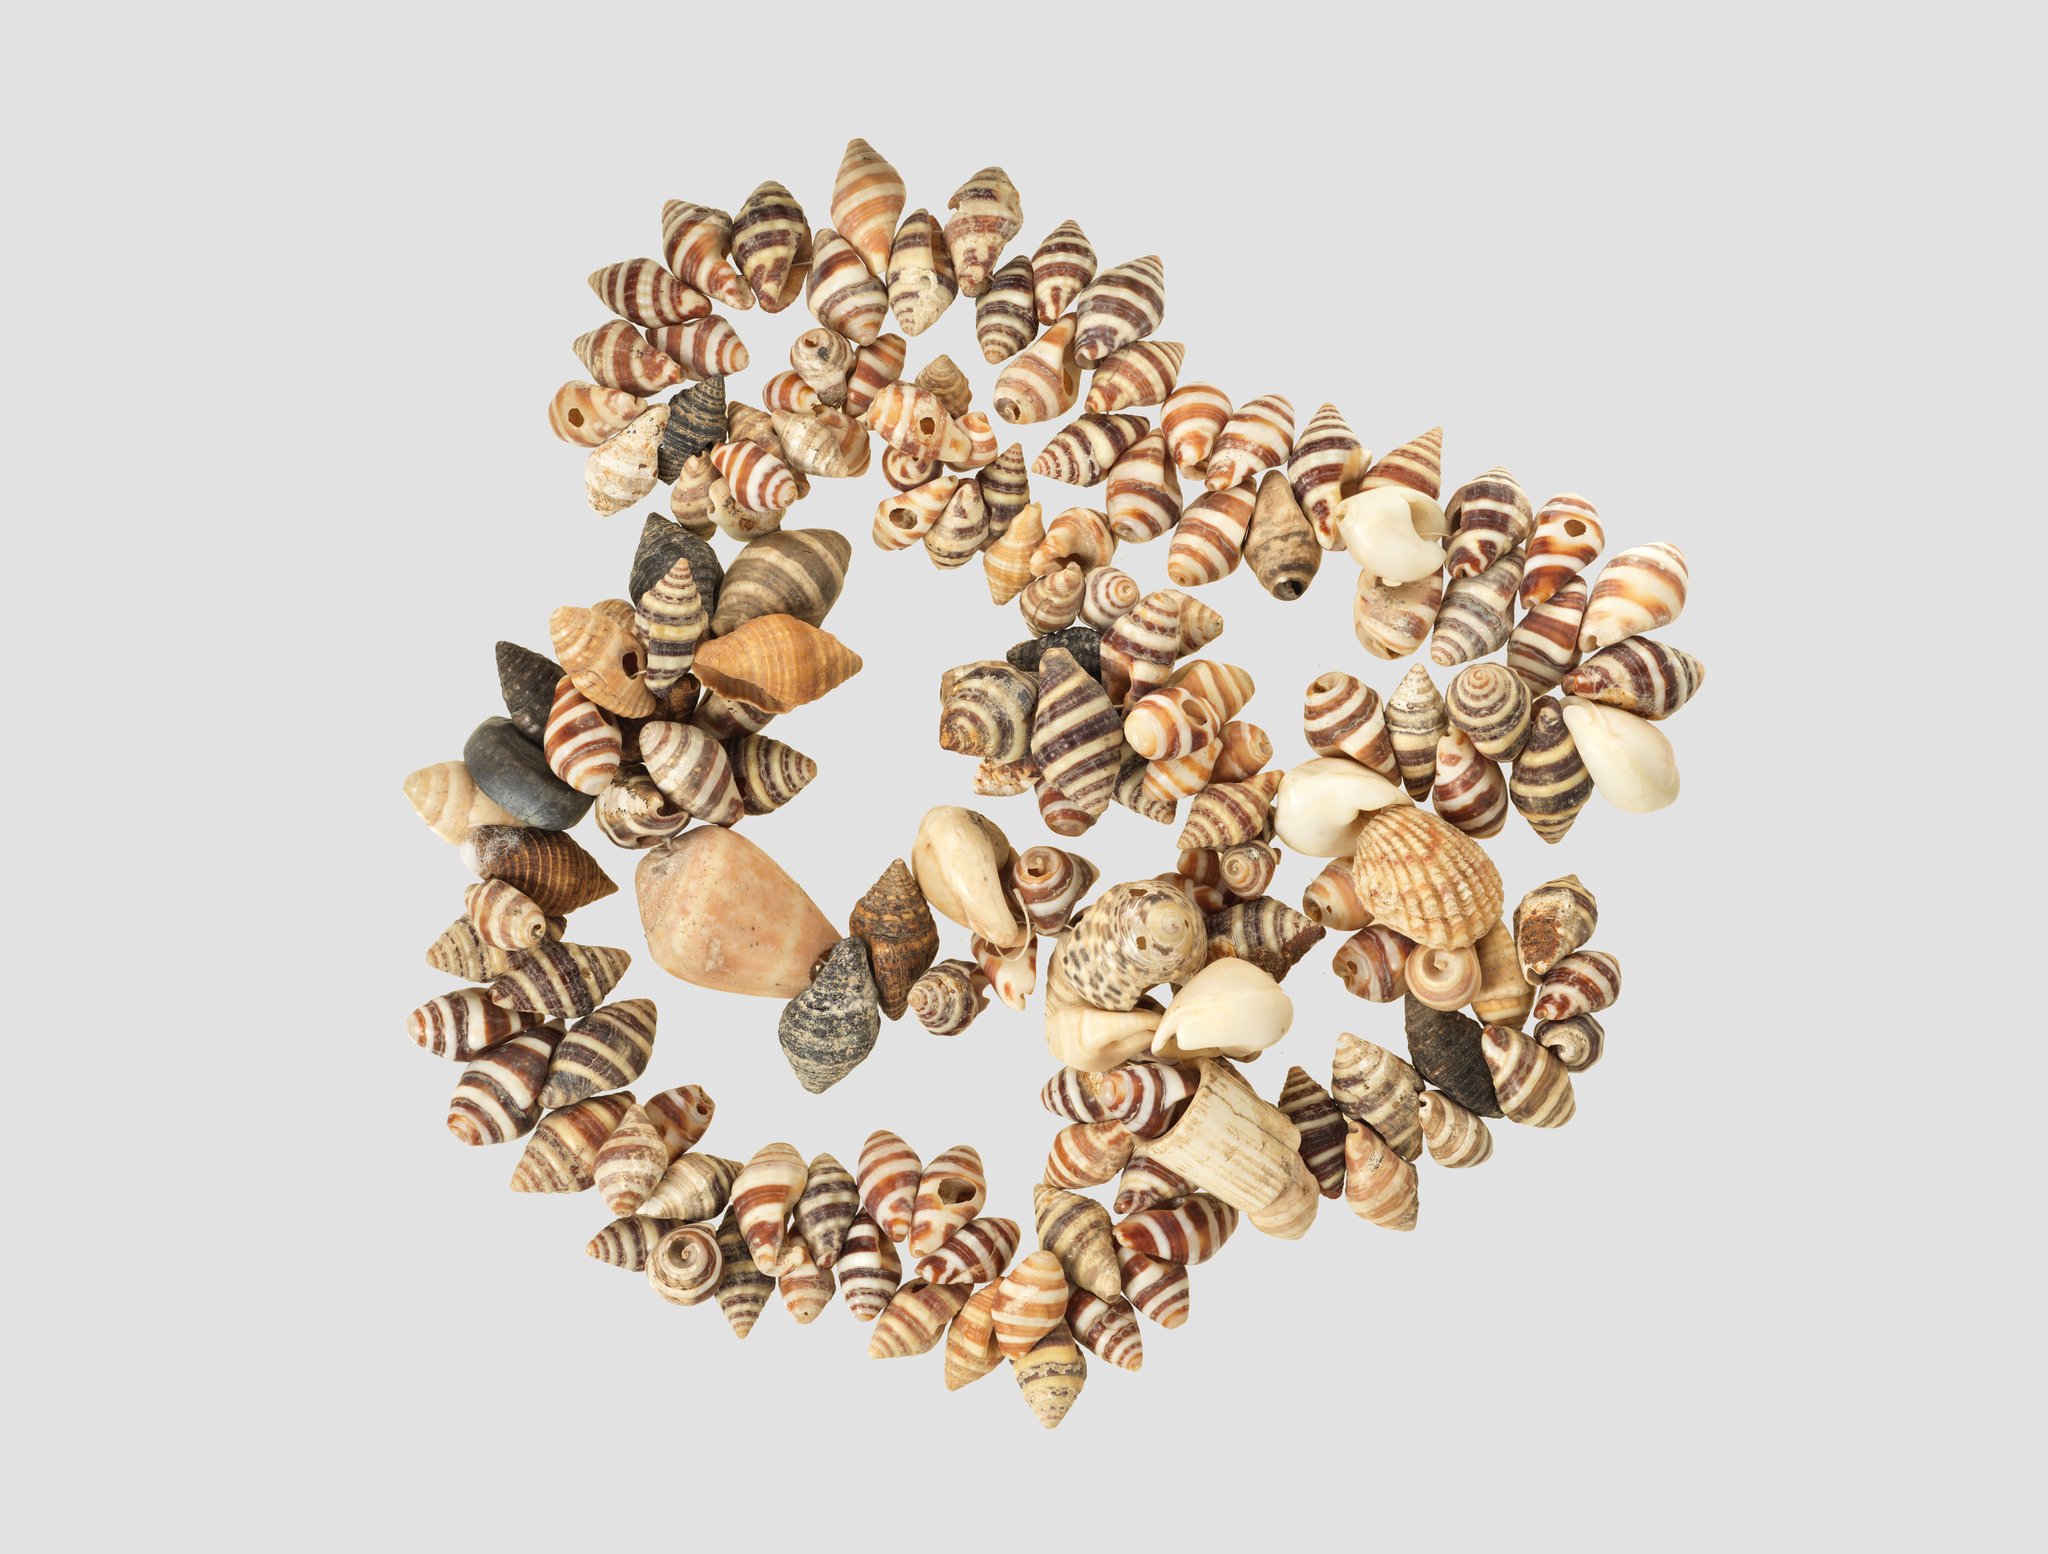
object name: necklace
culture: iranian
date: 900-801 BCE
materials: shell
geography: iran